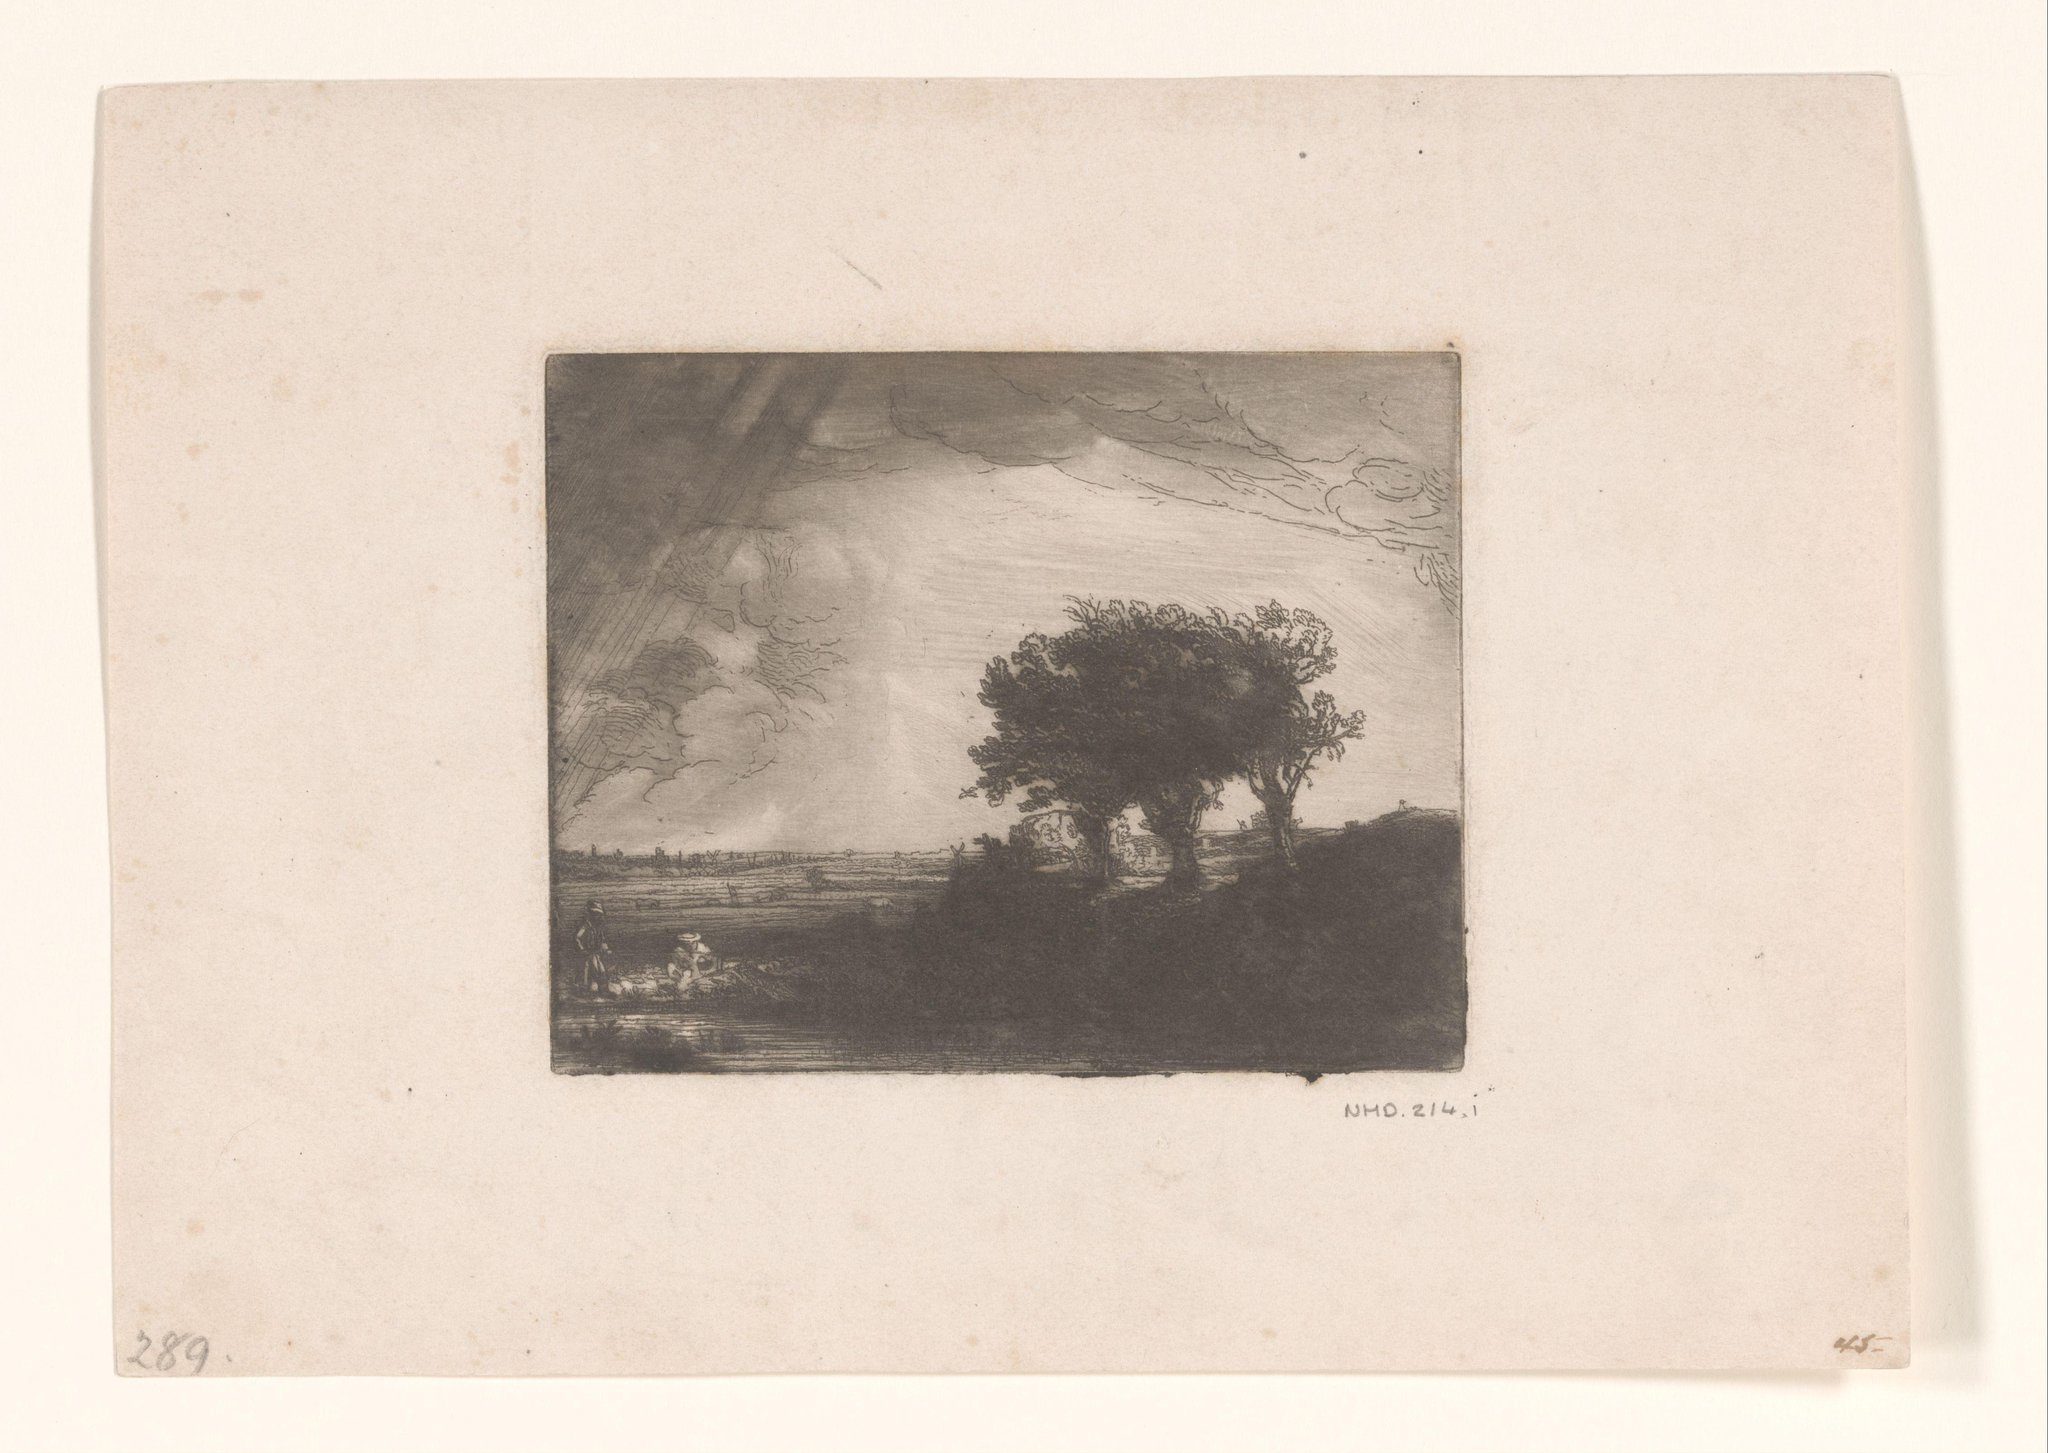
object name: print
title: The three trees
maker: Anonymous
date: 1643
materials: paper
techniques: etching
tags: trees, landscapes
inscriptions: collector's mark: Lugt 2228, collector's mark: Lugt 2760